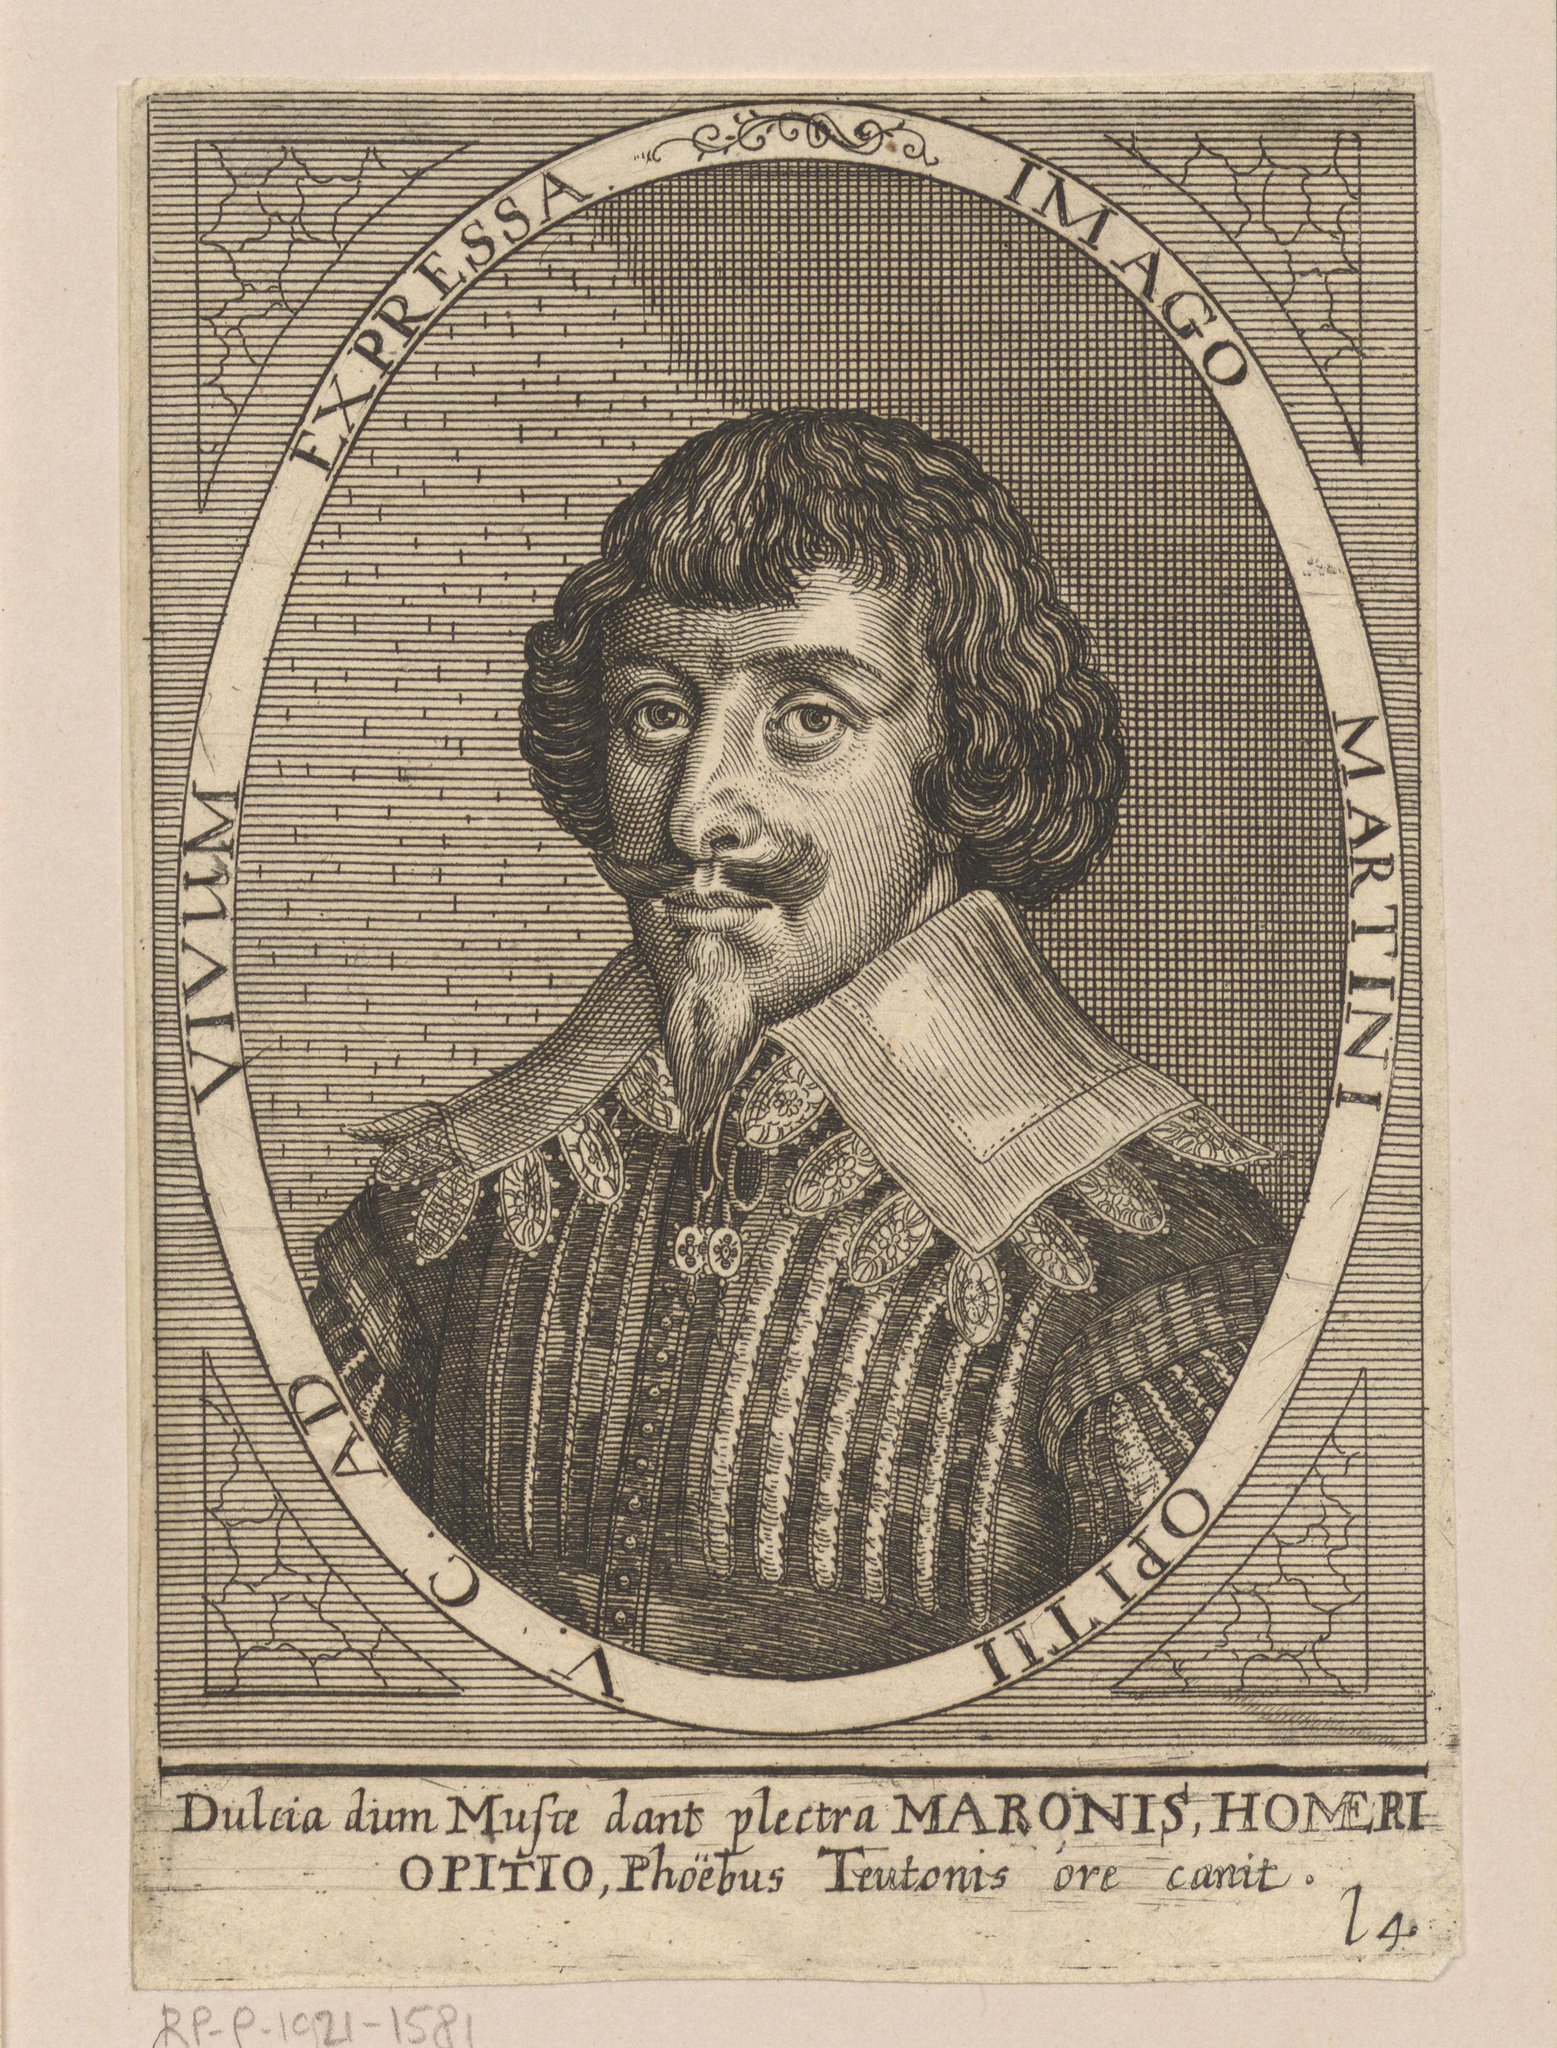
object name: print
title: Portretten van geleerden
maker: sebastian furck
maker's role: print maker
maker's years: 1600-1655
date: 1650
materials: paper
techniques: engraving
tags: poland, martin opitz, historical persons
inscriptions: collector's mark: Lugt 2228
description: Prent mogelijk uit: Bibliotheca chalcographica. Frankfurt am Main: Johannes Ammon, 1650. Prent voor het eerst (zonder nummering) verschenen in: Boissard, Jean Jacques. Icones quinquaginta virorum illustrium doctrina & eruditione praestantium ad vivum effictae. Frankfurt am Main: s.n., 1597.